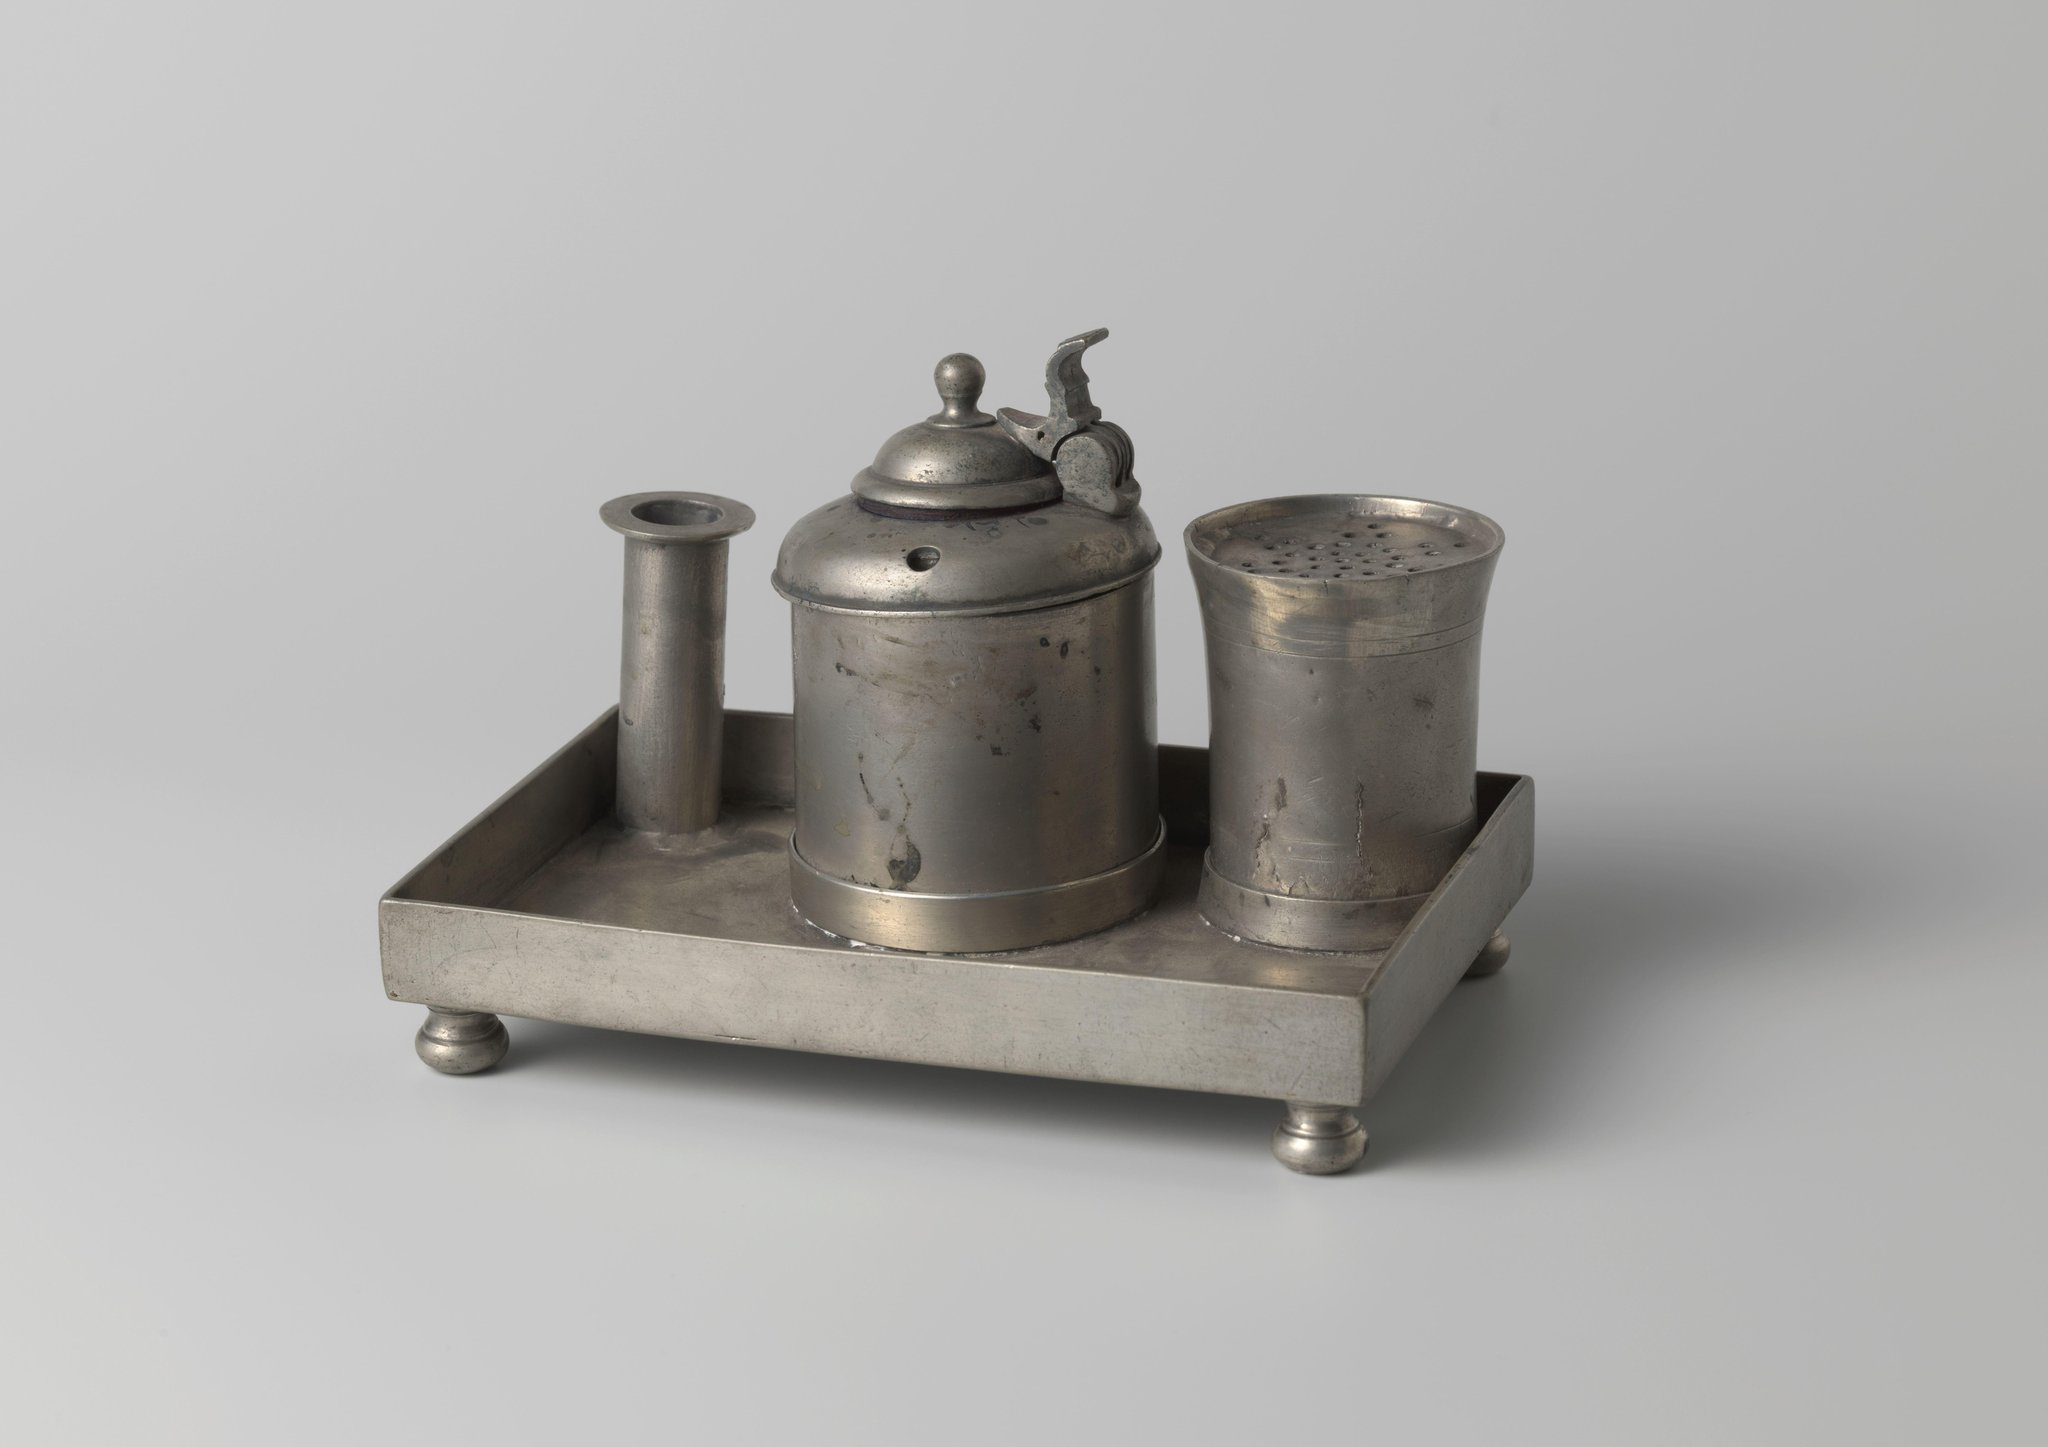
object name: inkstand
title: Inktstel van tin met inktpot en zandpot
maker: Anonymous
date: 1850-1900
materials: tin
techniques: casting, turning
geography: netherlands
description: Inktstel van tin. Op vier doppen ligt een rechthoekige plaat met opstaande rand. In de bak in de linker achterhoek een hoge pennenkoker. Daarnaast bijna tegen de achterwand aan twee cirkelvormige laag, opstaande randen voor de inktpot en de zandstrooier. De inktpot in het midden heeft een cylindrisch lichaam. De binnenbak is smaller en de gewelfde bovenzijde valt over de buitenpot. In het midden van de welving een klokvormig deksel dat met een tweekakig scharnier is te openen. Daarnaast de zandstrooier met cylindrisch lichaam. De bovenzijde is opengewerkt met kleine rondjes die een ster vormen.